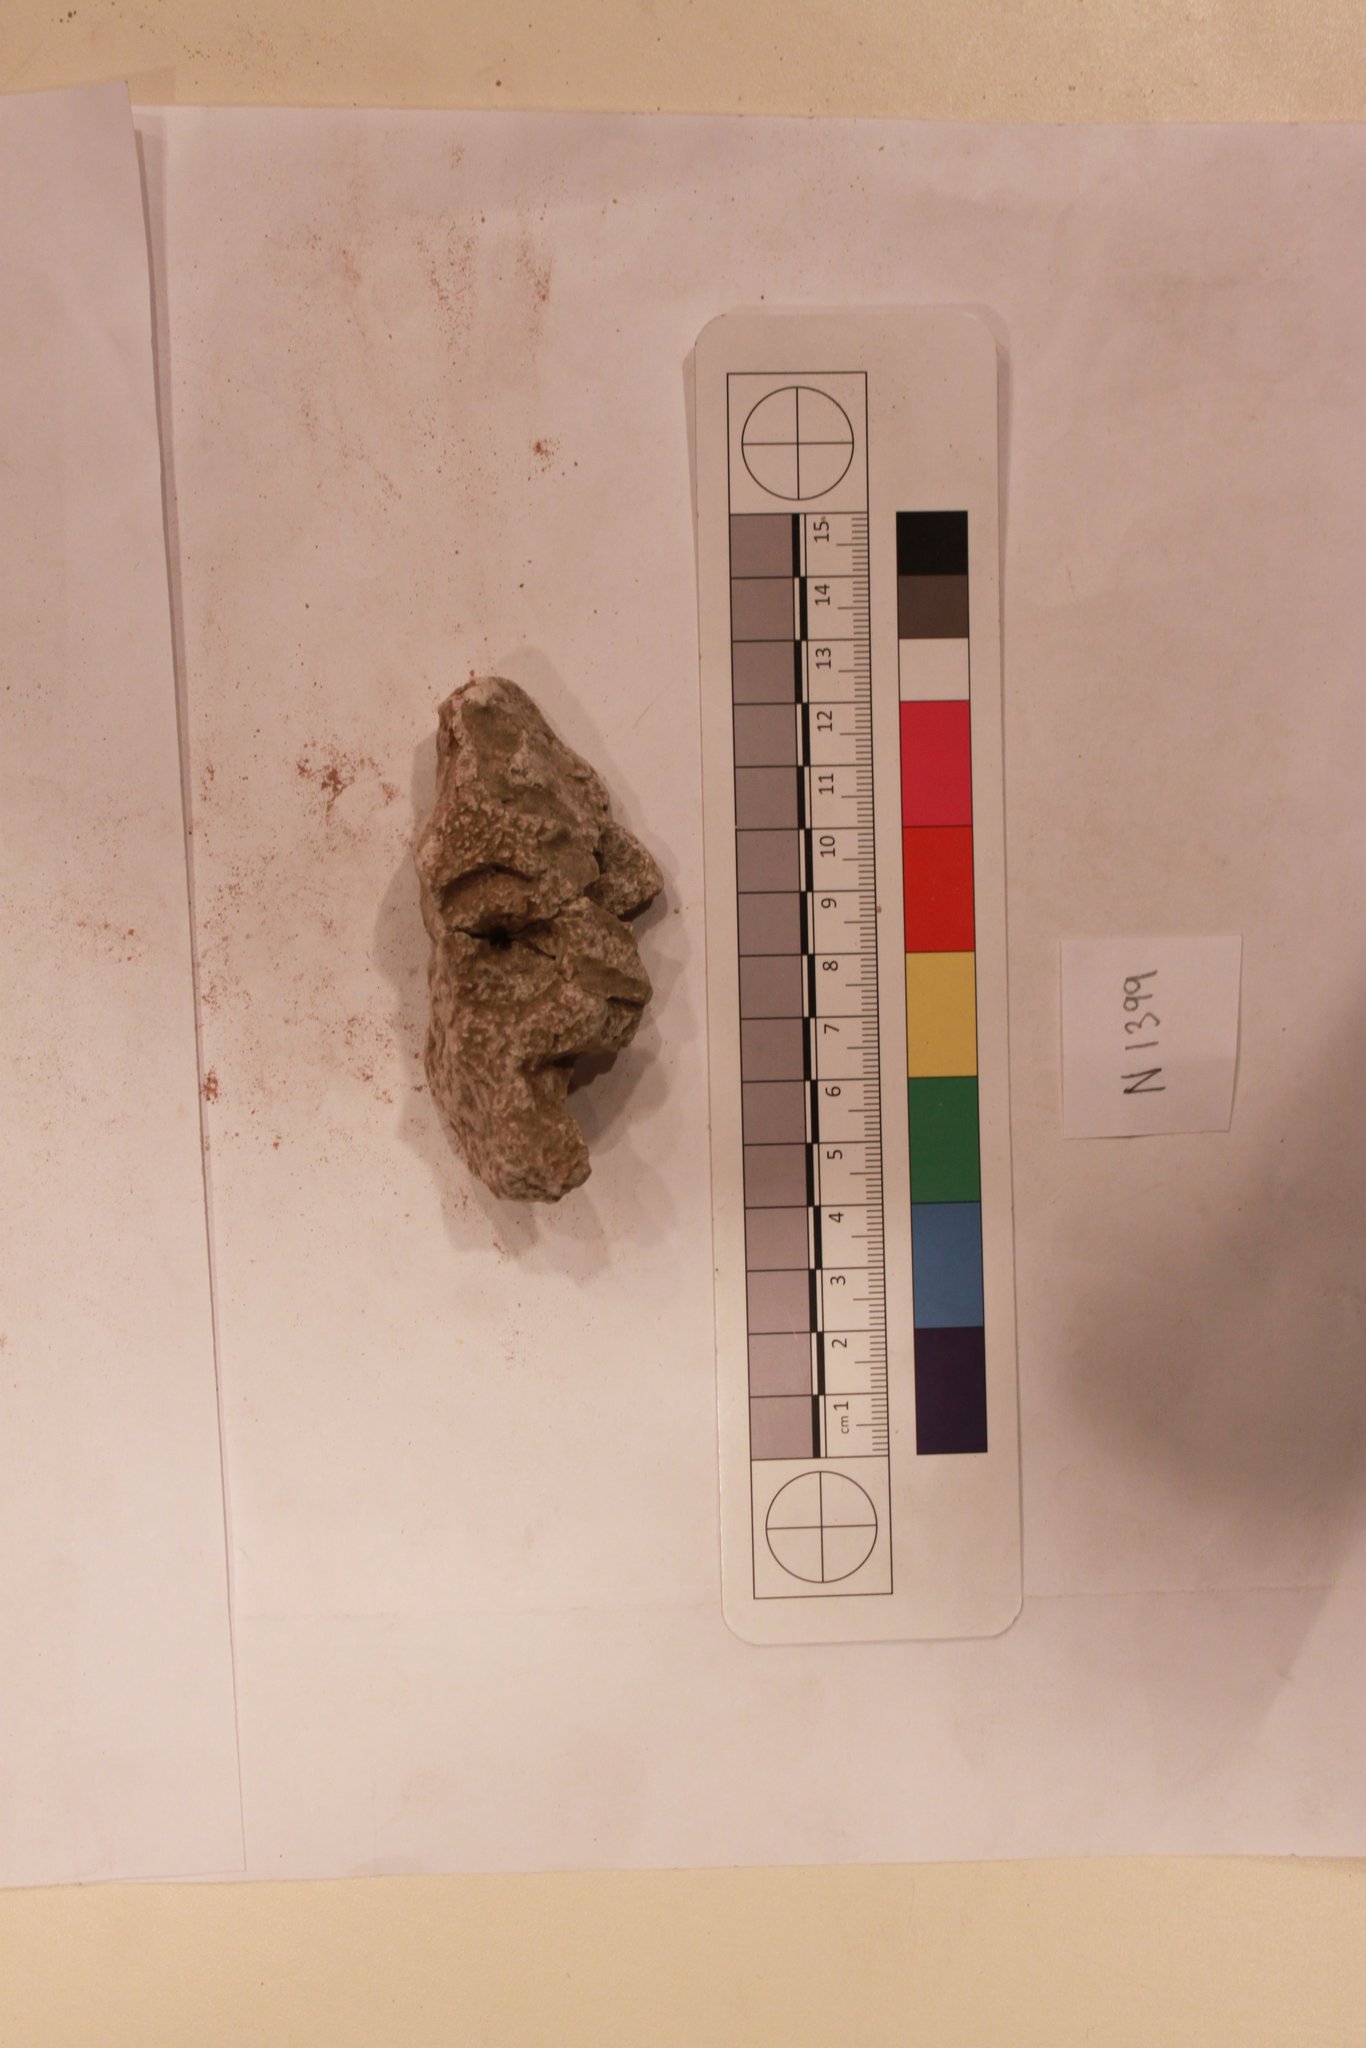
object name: fragment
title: Stucco Fragment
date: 701-1200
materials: plaster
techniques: carving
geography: iran